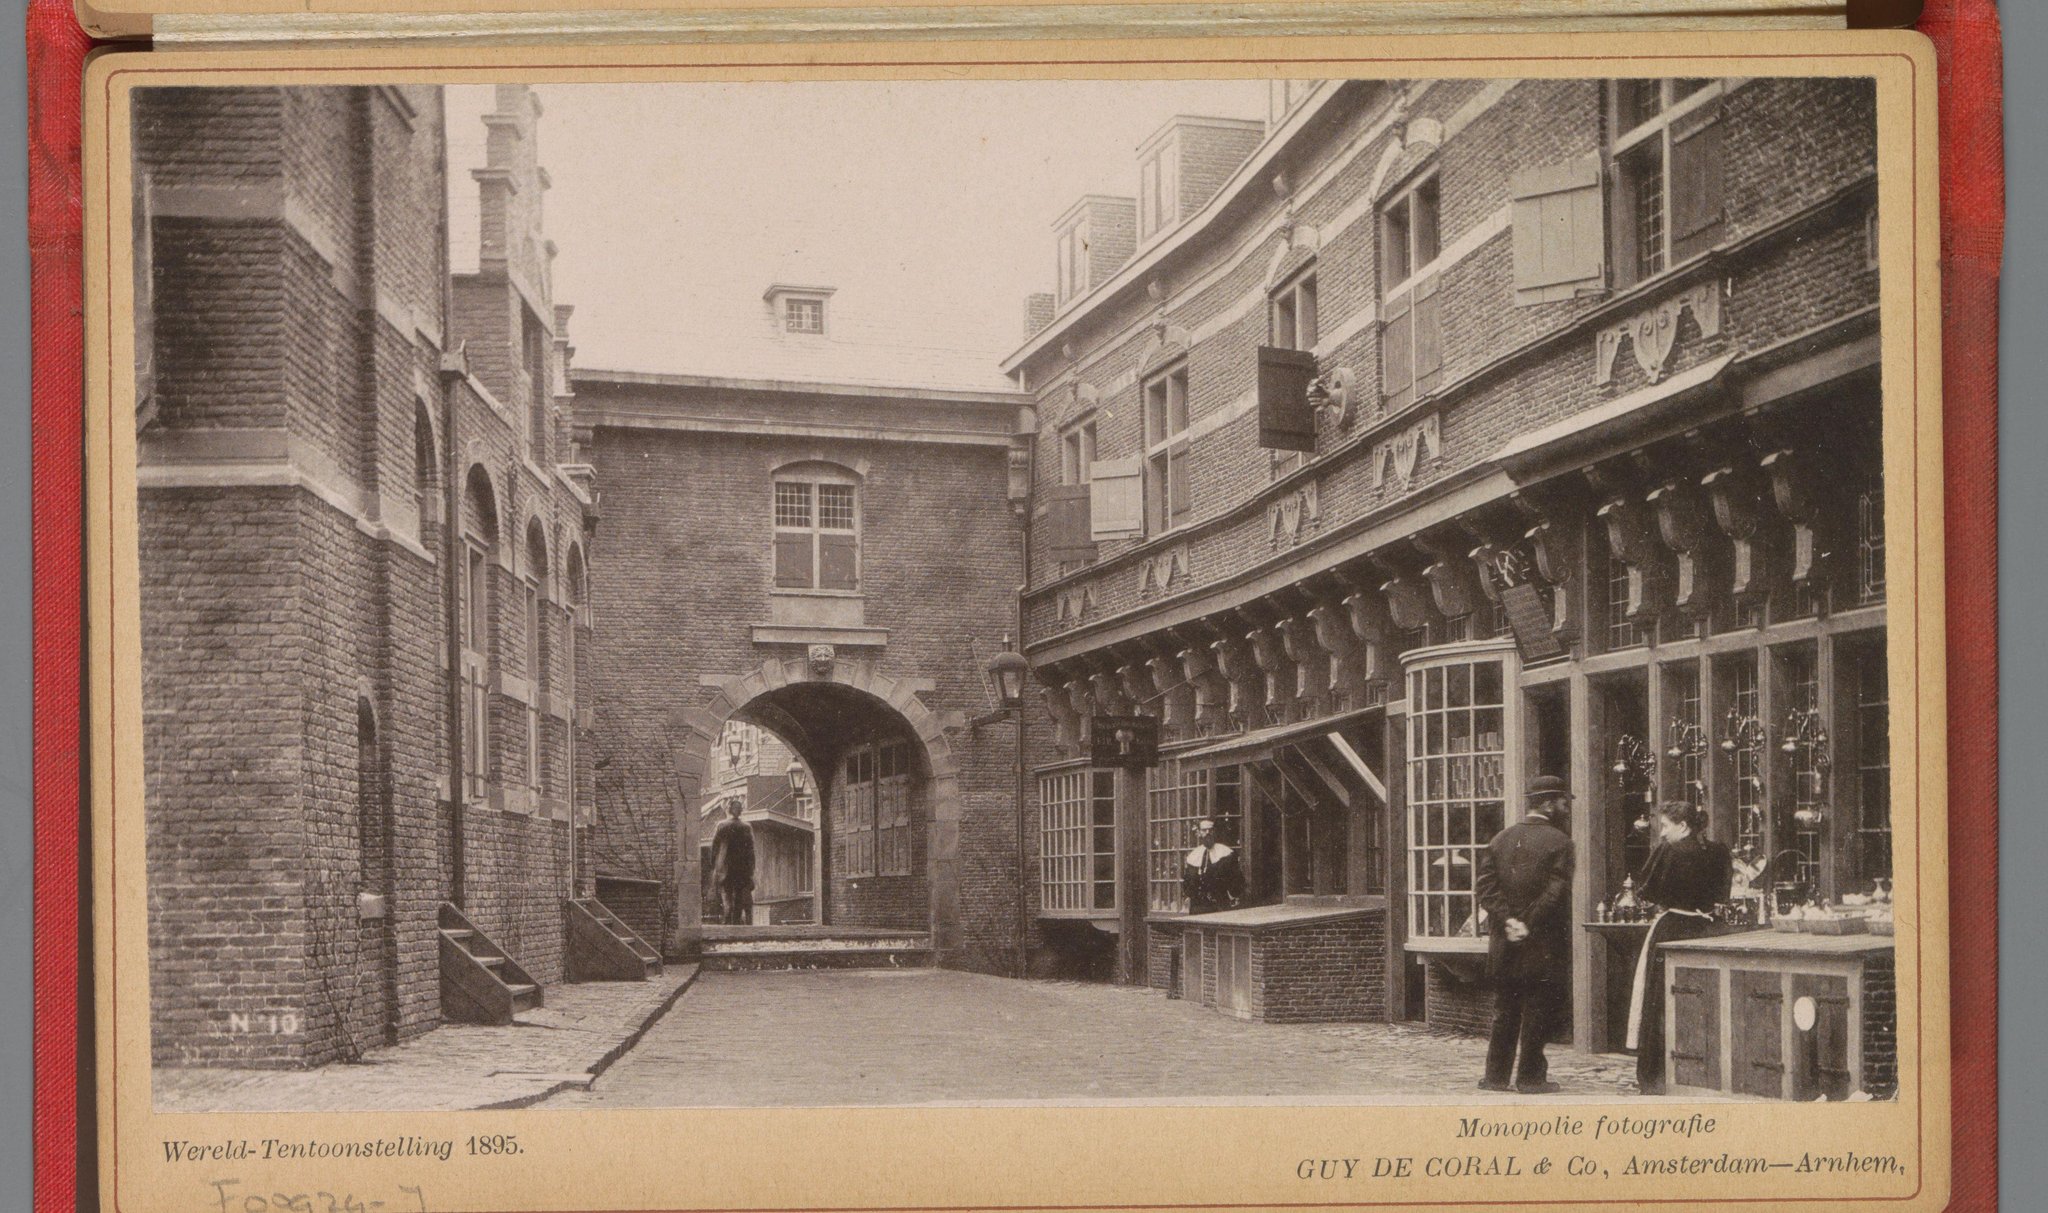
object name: photograph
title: Straat met oud-Hollandse gevels en poort tijdens de Wereldtentoonstelling voor het Hotel- en Reiswezen op het Museumplein in 1895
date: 1895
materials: cardboard, paper, ink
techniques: photograph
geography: amsterdam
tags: gate, entrance, façade (of house or building), street, prospect of city, town panorama, silhouette of city, temporary exhibition, 'salon', amsterdam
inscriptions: number: ‘No. 10’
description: Onderdeel van Fotoalbum met opnames van de Wereldtentoonstelling voor het Hotel- en Reiswezen op het Museumplein in 1895.